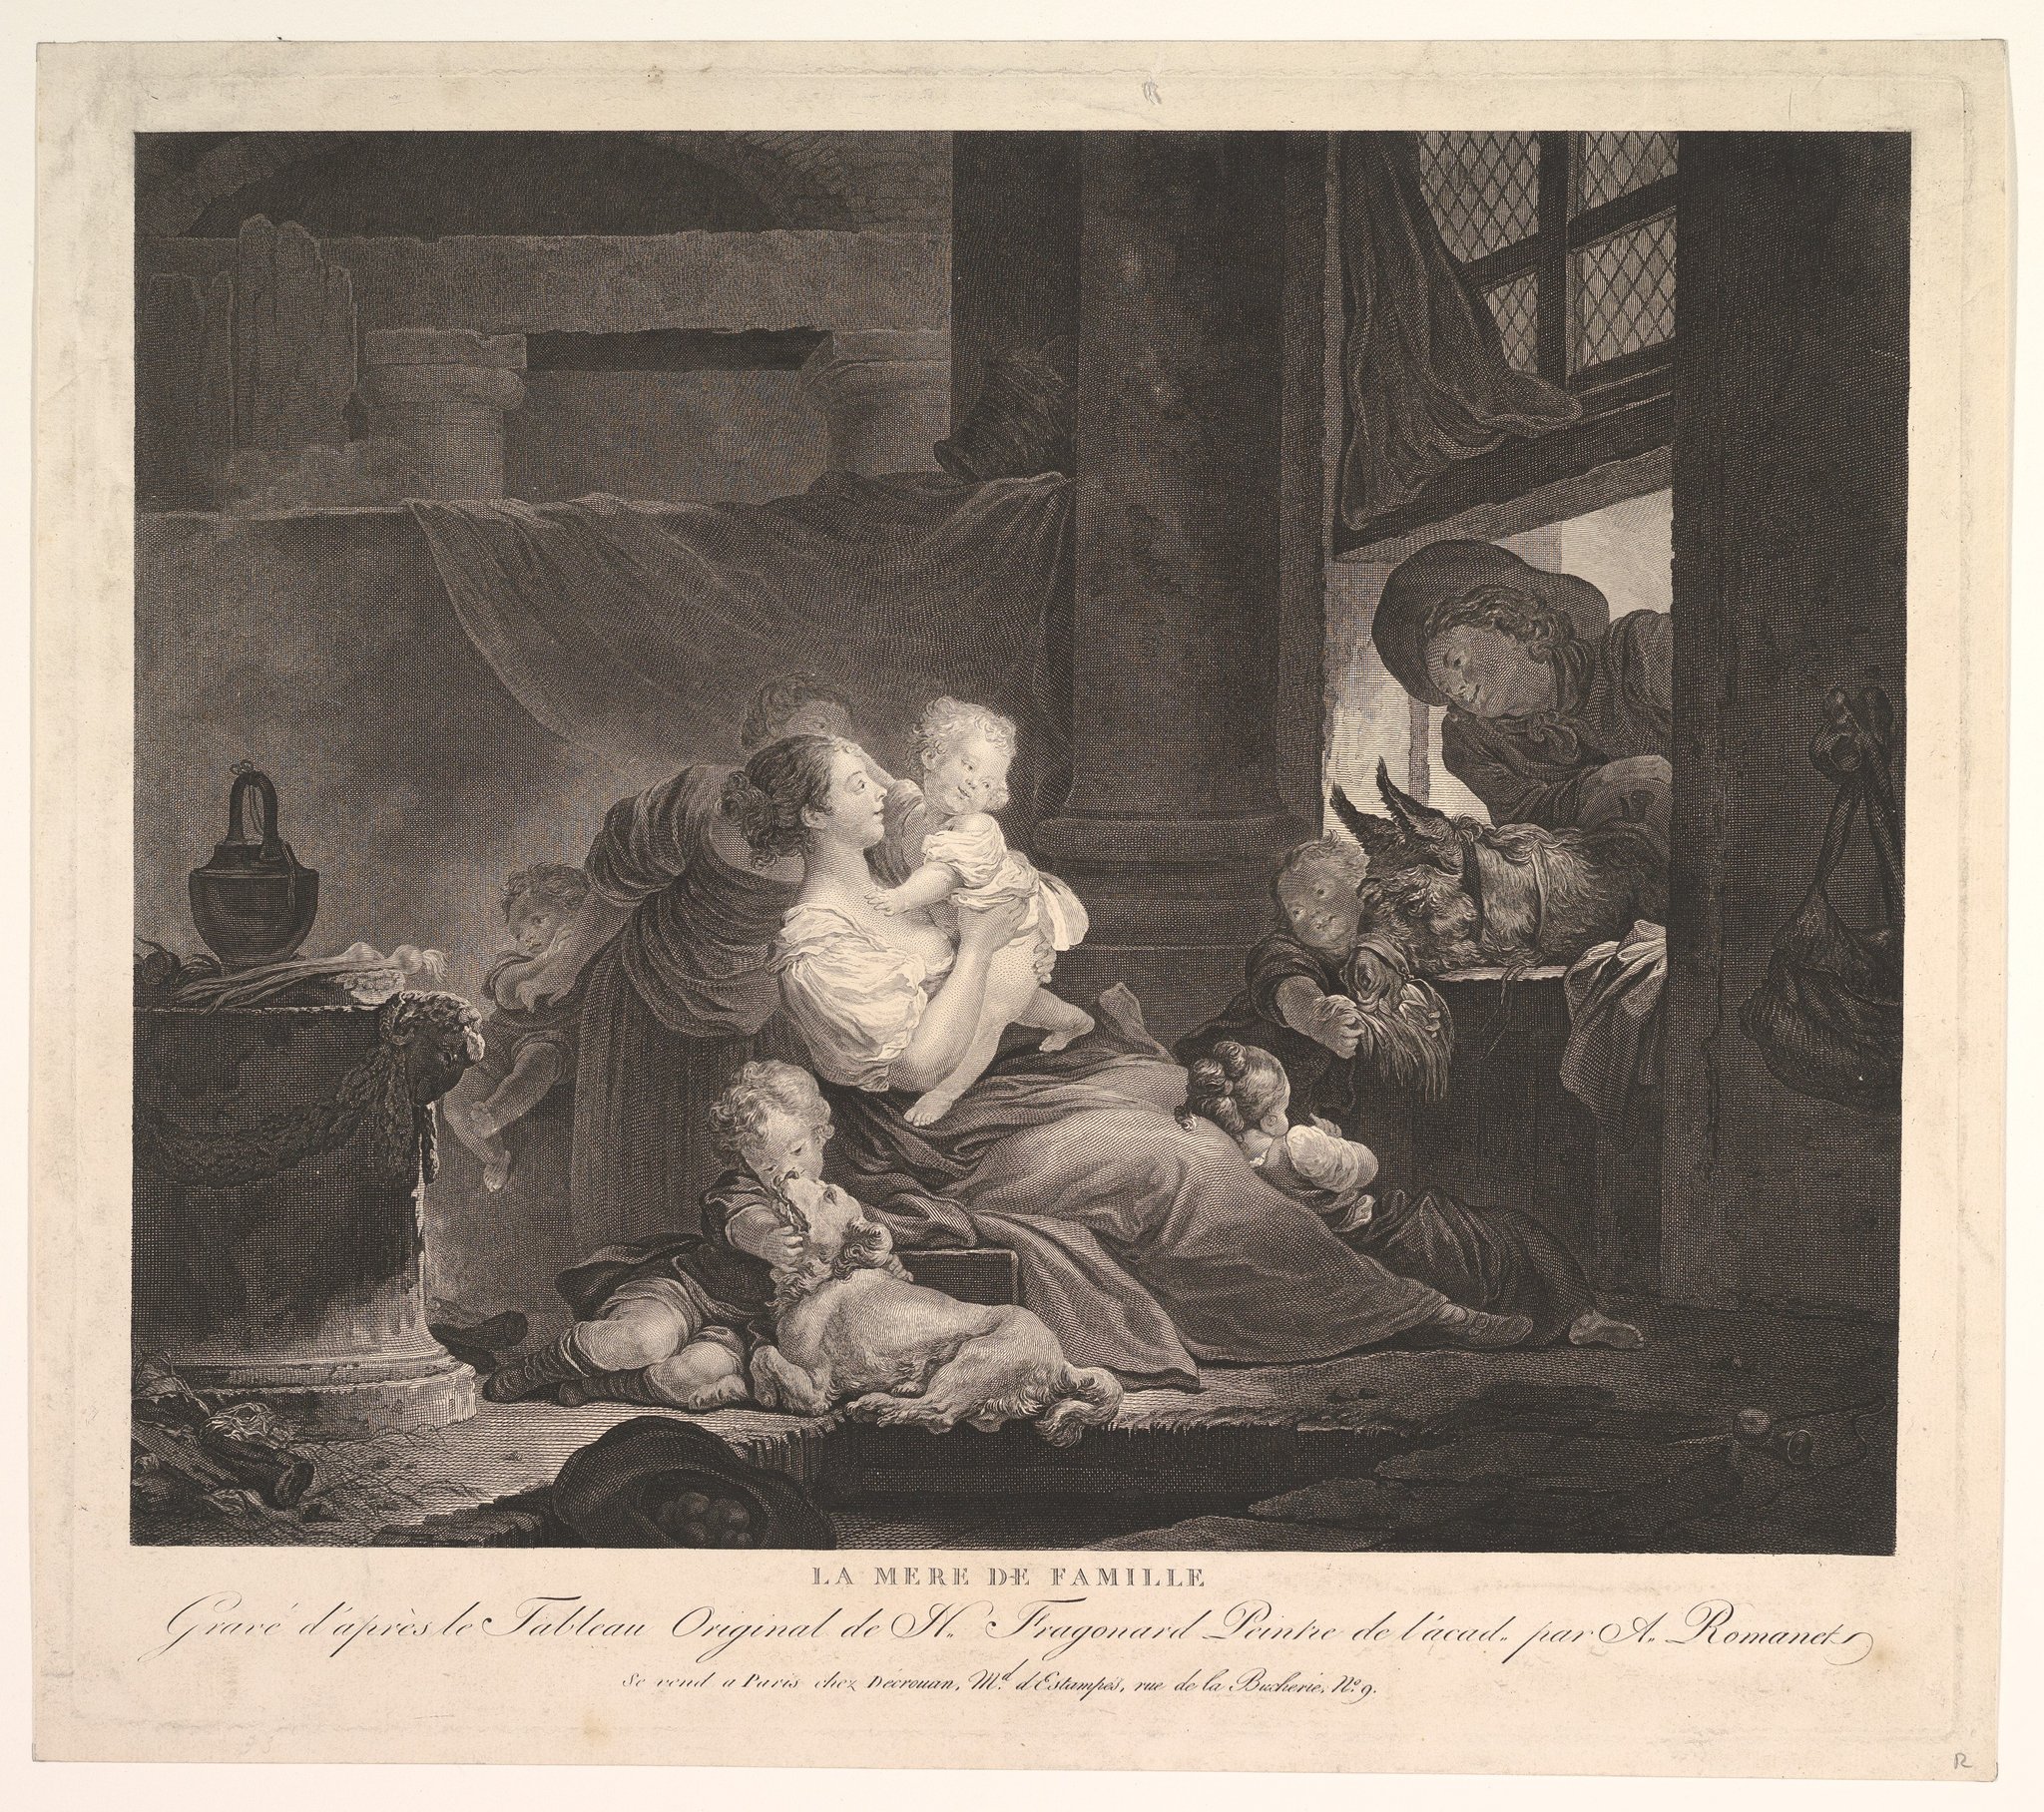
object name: print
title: La Mere de Famille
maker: jean honoré fragonard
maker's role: artist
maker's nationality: french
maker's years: 1732-1806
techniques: etching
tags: boys,girls,mothers,dogs,family